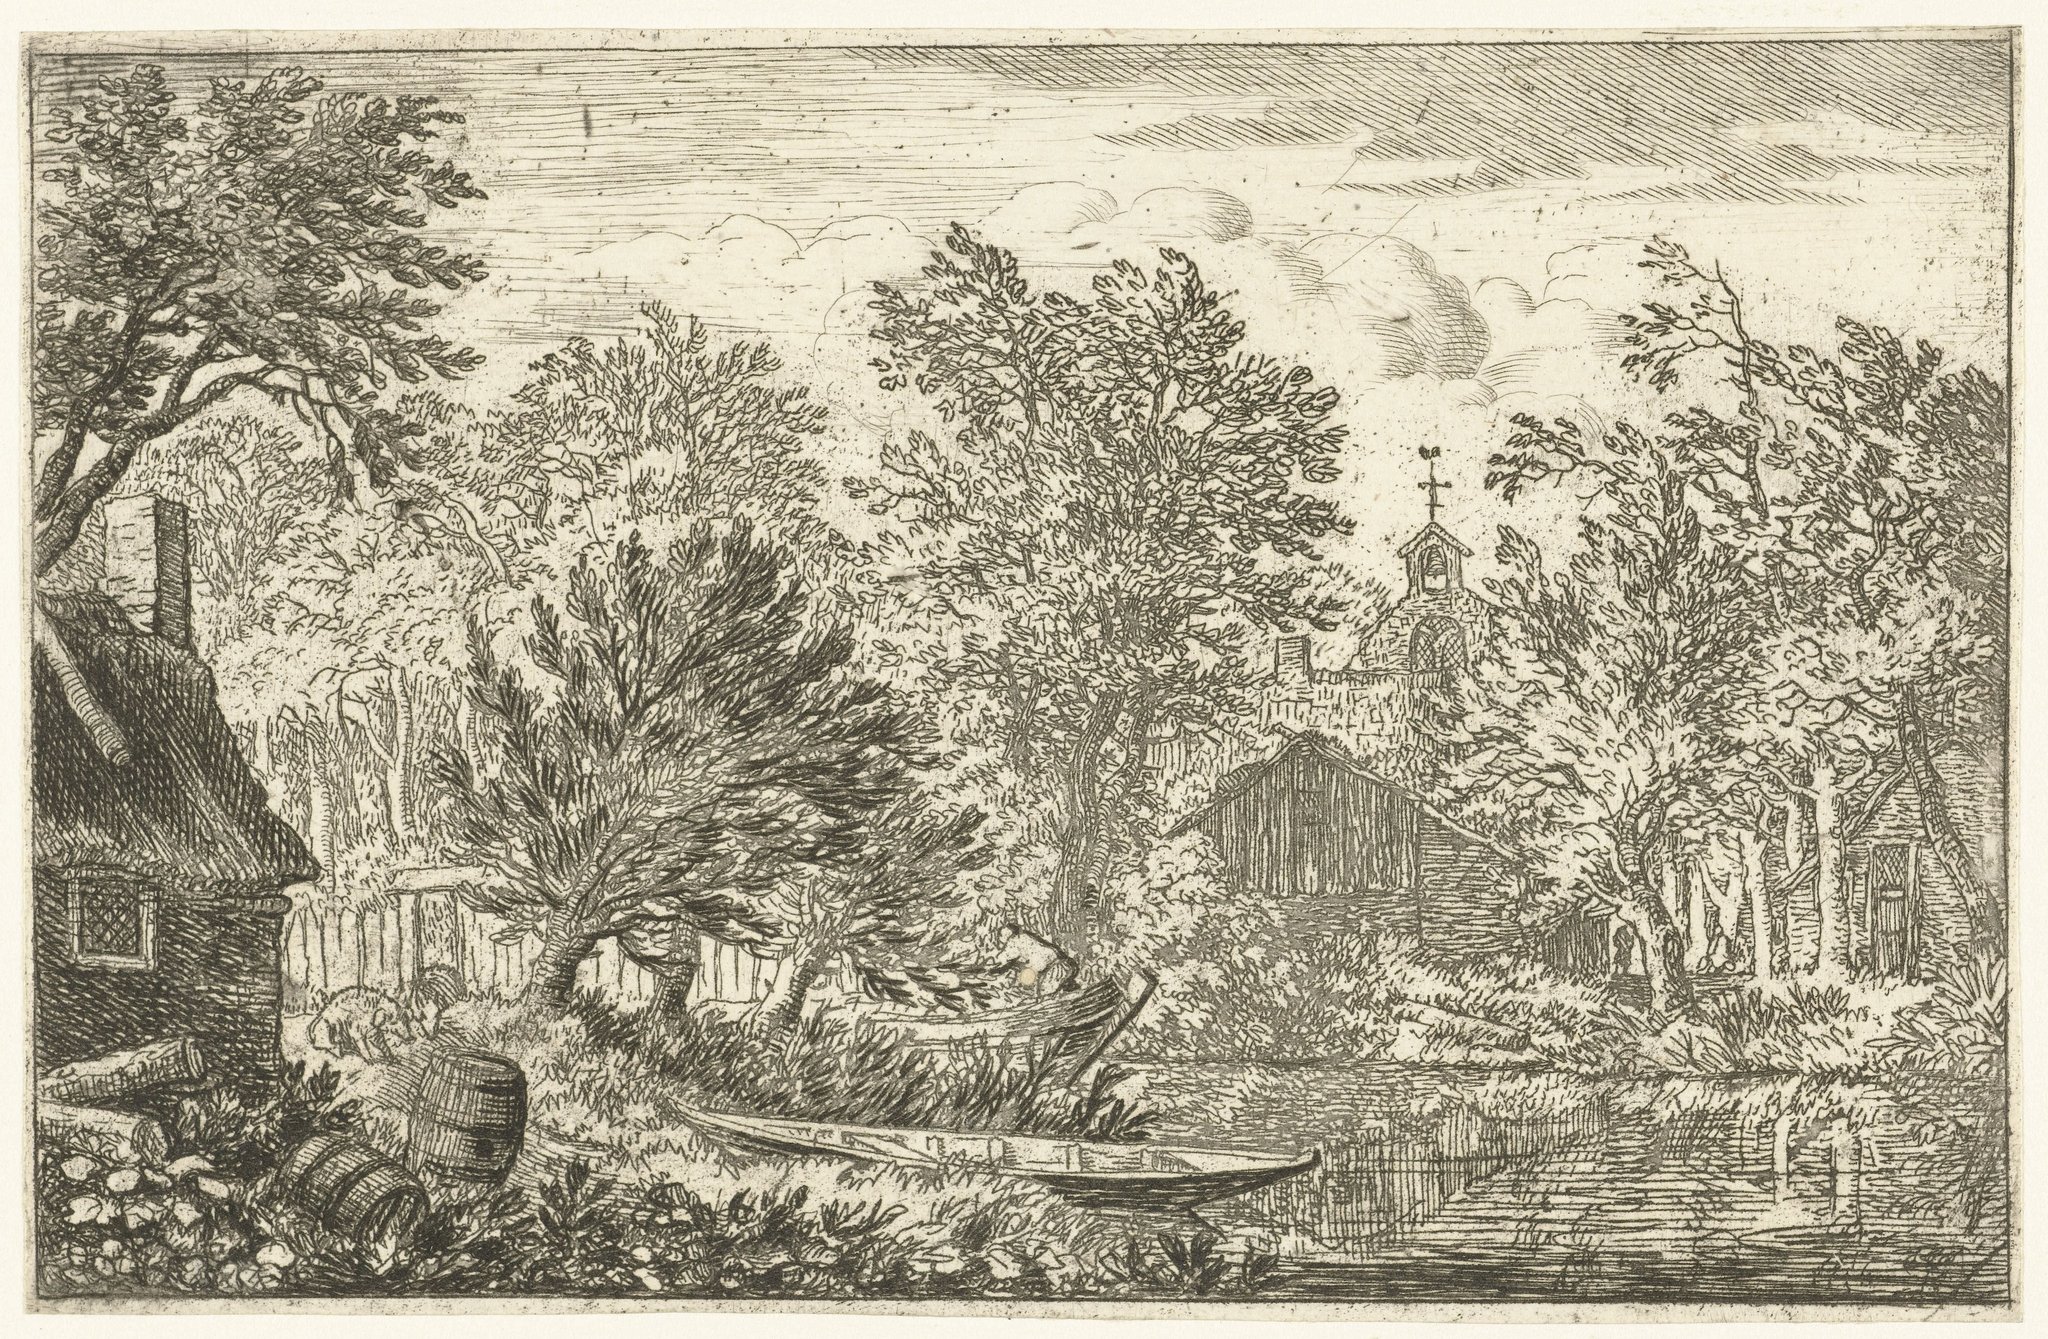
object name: print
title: Dorpsgezicht met roeiboot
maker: allaert van everdingen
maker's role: draughtsman, painter, print maker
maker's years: 1621-1675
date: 1631-1675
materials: paper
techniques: etching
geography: netherlands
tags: canals, waters (in village)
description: Gezicht op huizen en bomen langs het water. Naast het huis op de voorgrond enkele houten tonnen en op de oever een roeiboot.